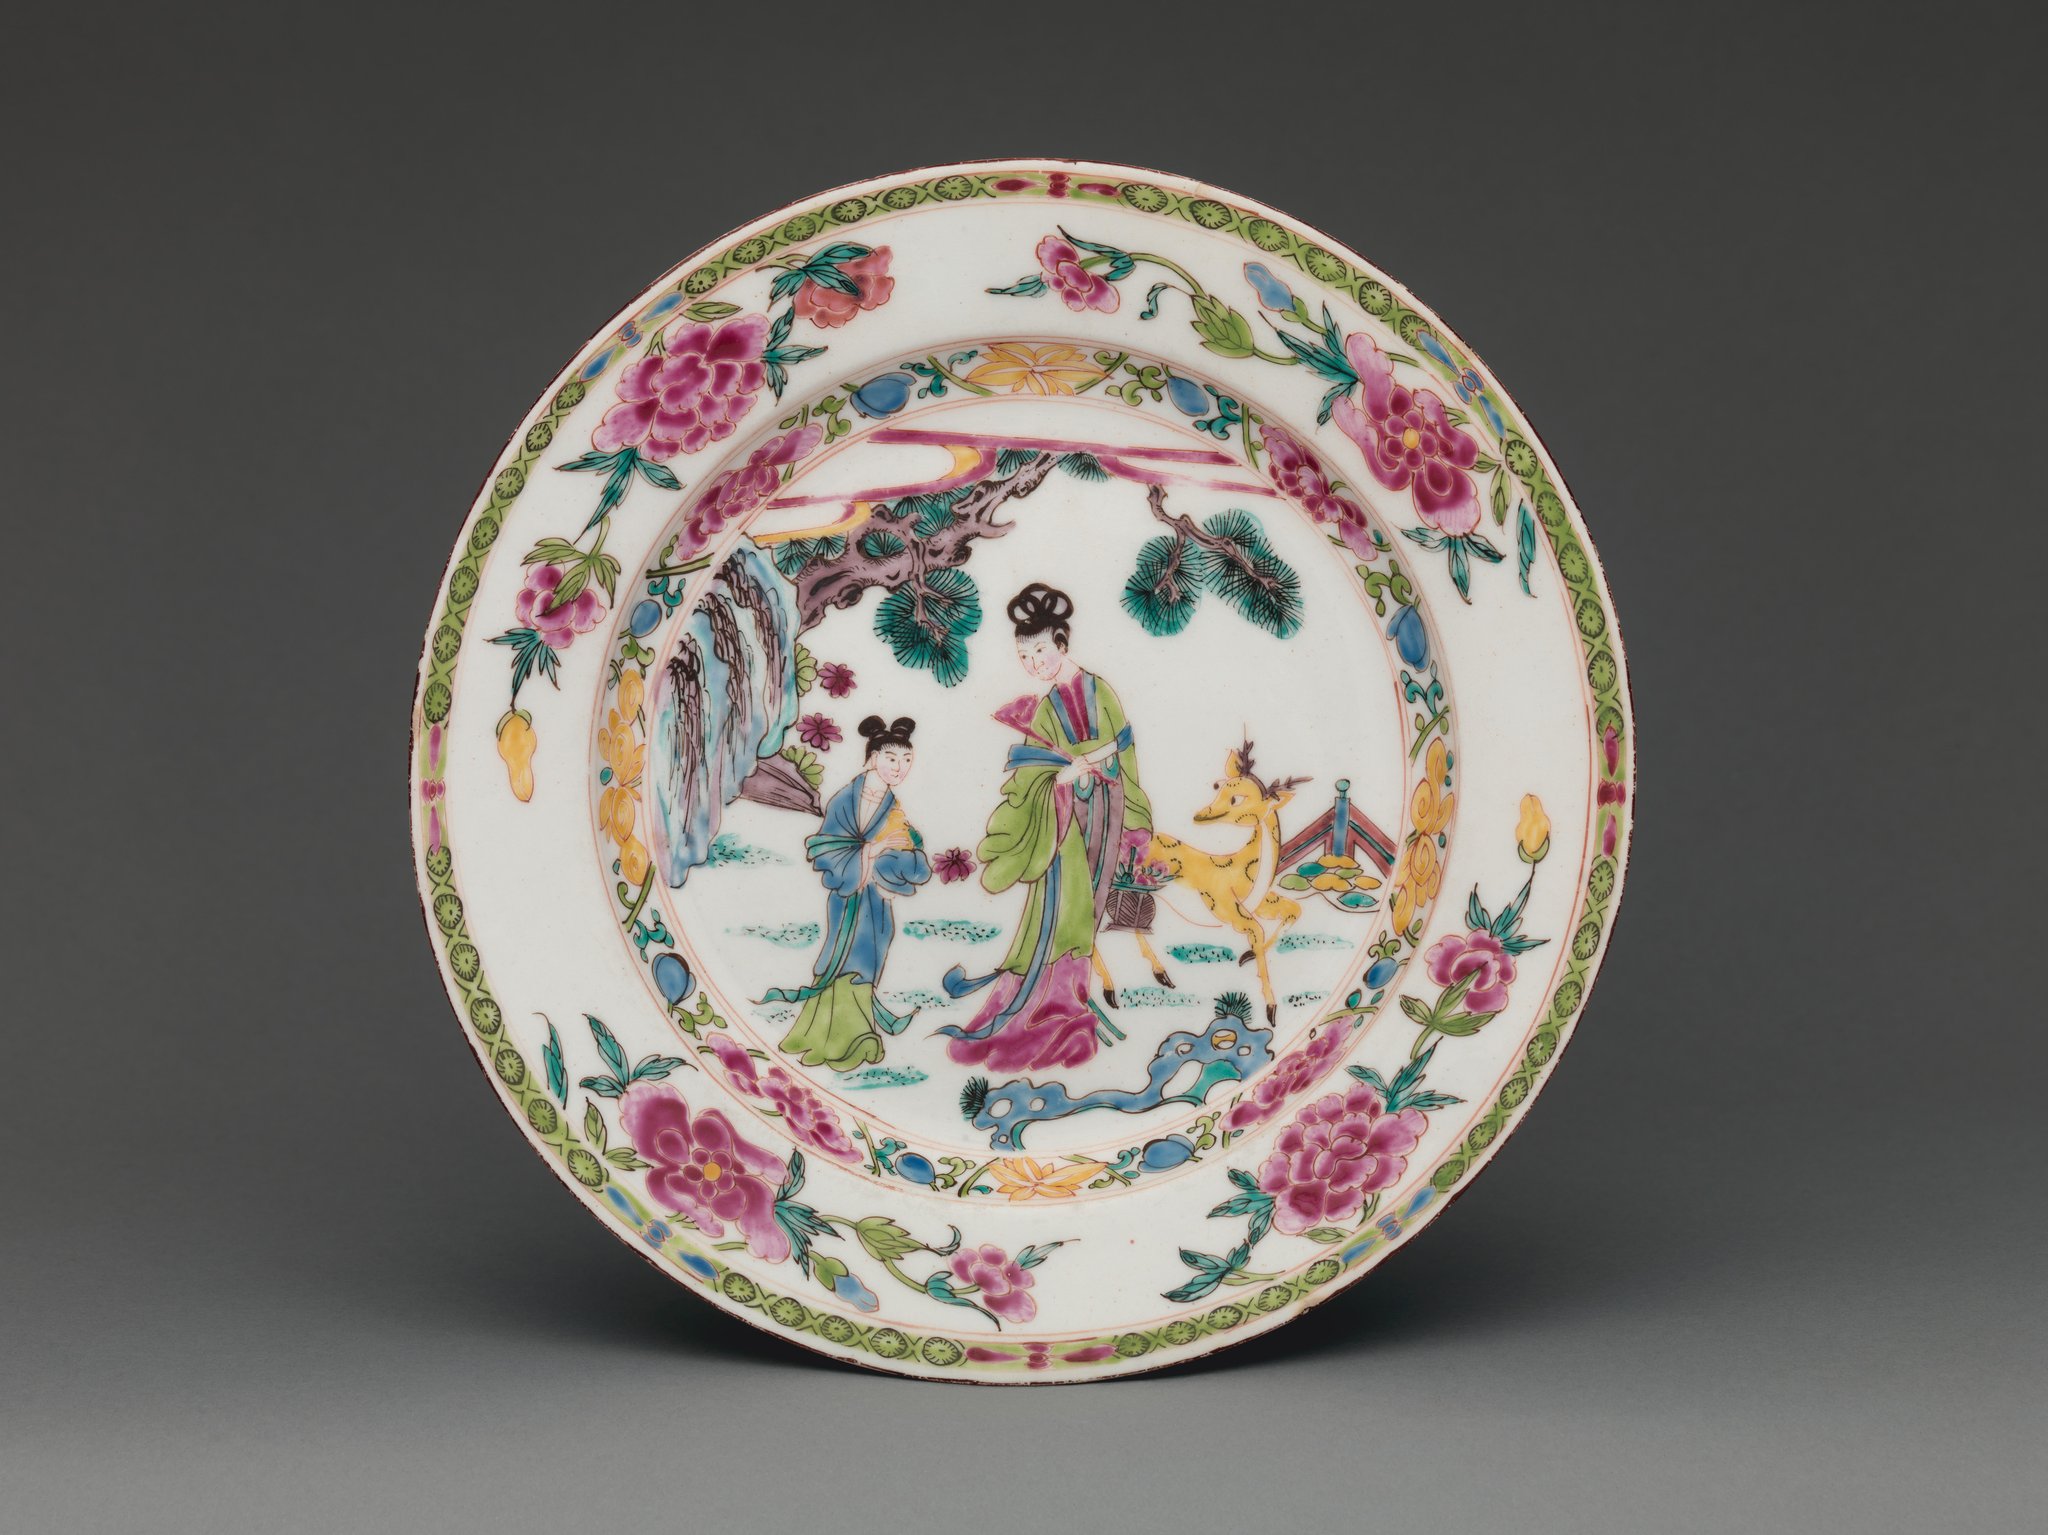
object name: plate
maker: bow porcelain factory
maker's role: manufactory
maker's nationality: british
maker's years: 1747-1776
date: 1755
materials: enamel, soft paste porcelain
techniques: polychrome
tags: women,deer,flowers